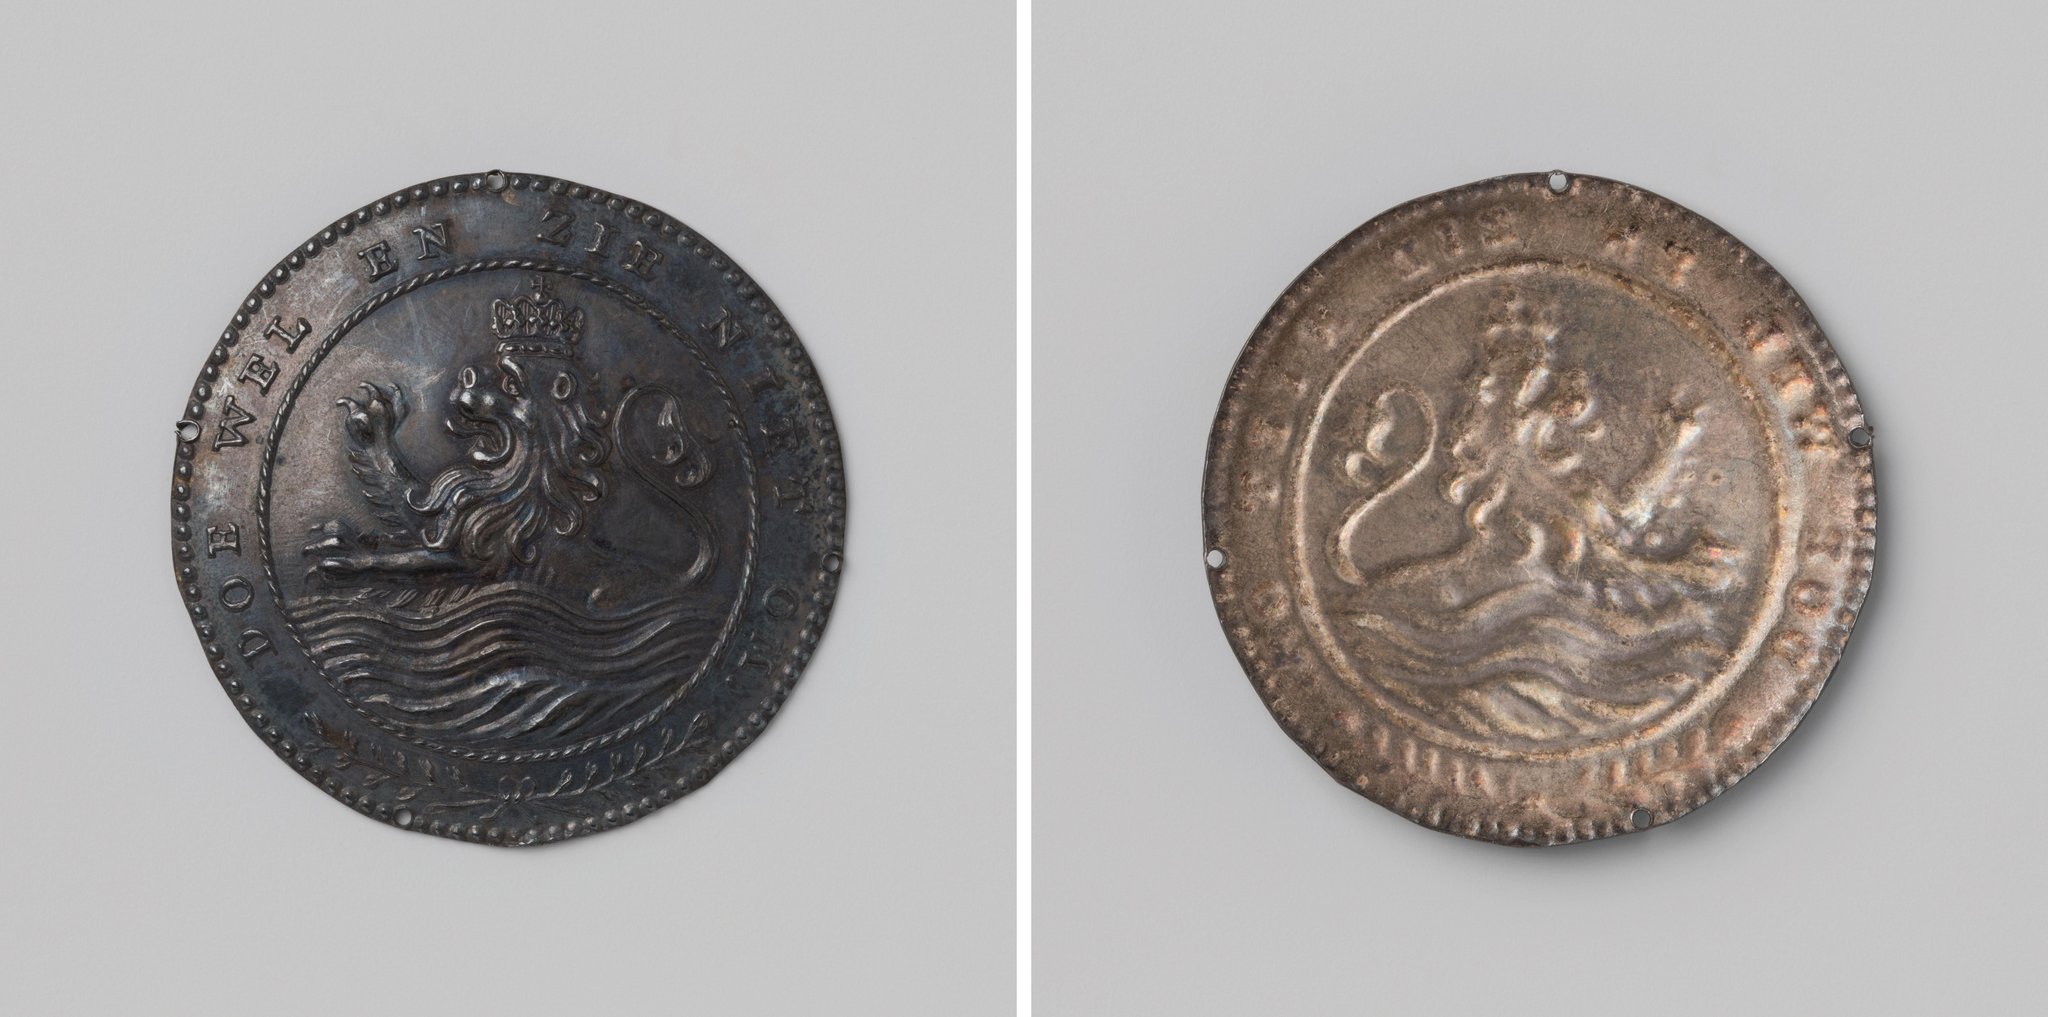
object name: ordeteken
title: Grootkruis van de Orde van de Unie, behoord hebbend aan I.J.A. Gogel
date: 1811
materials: silver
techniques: striking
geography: netherlands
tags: staatsman, intendant-generaal van financien, secretaris van staat voor financien, minister van financiën, izaak jean alexandre gogel, orde van de unie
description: Eenzijdig, enigszins bol middenschildje met vier gaatjes erin. Voorzijde: gekroonde leeuw met geheven klauwen, tot middel in golven binnen omschrift. Keerzijde: blanco.